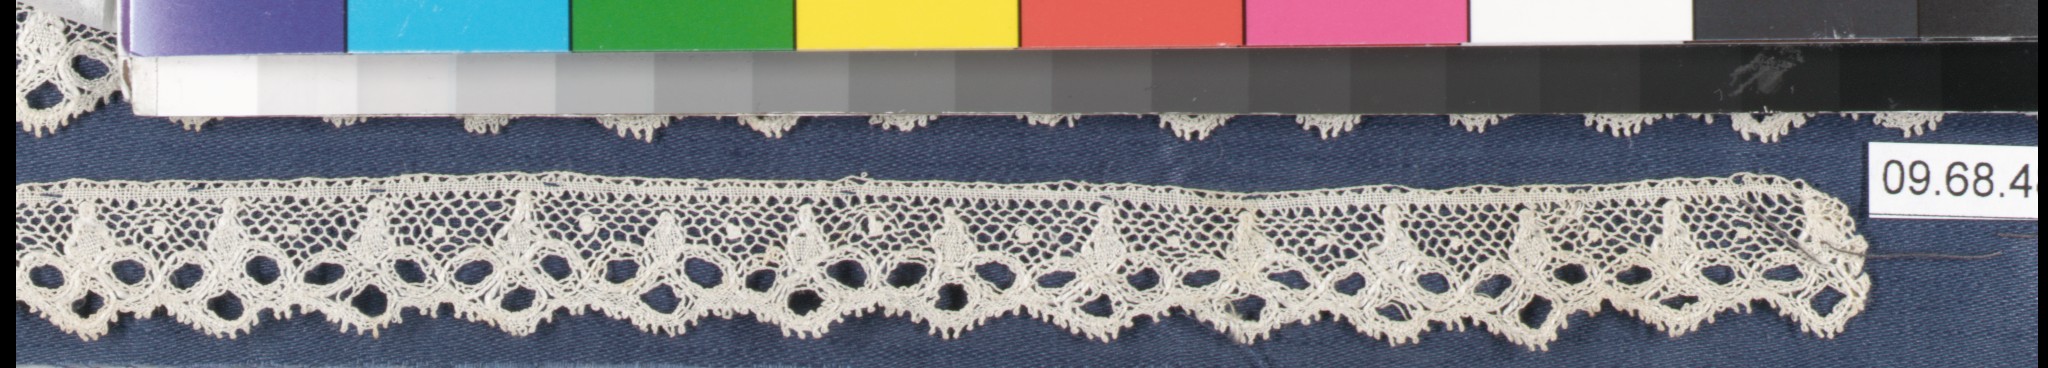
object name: border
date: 1801-1900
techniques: lace